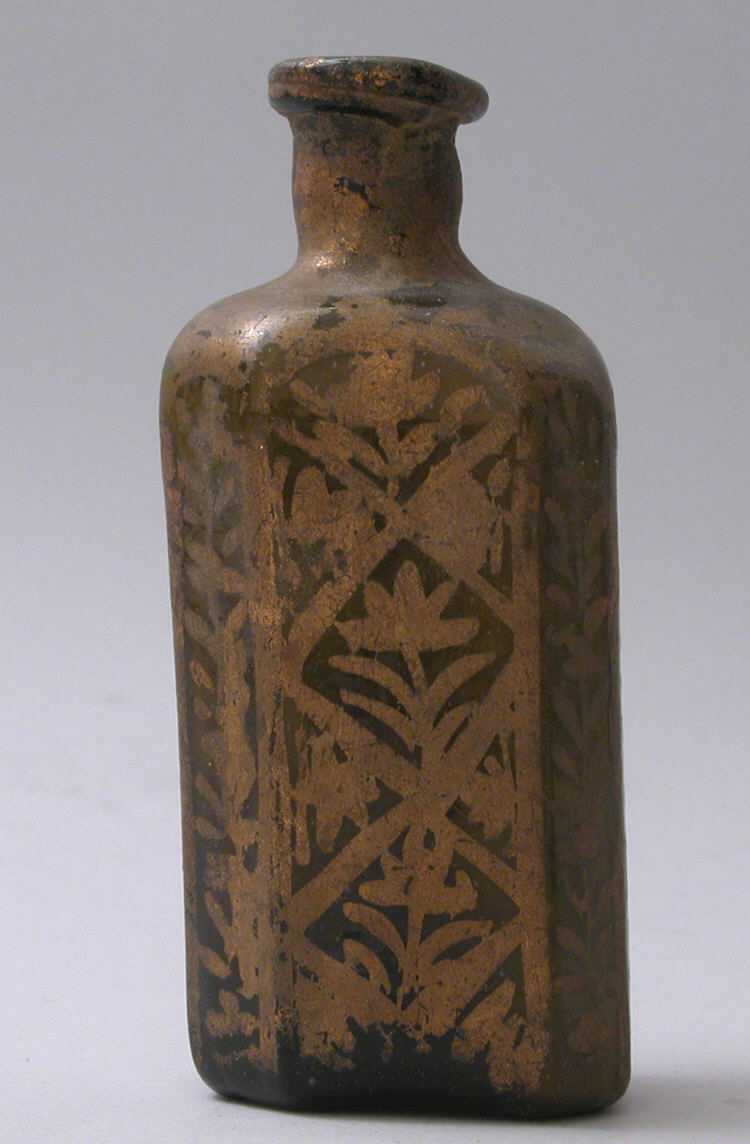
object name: bottle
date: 1601-1800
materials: glass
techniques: glassblowing, painting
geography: india